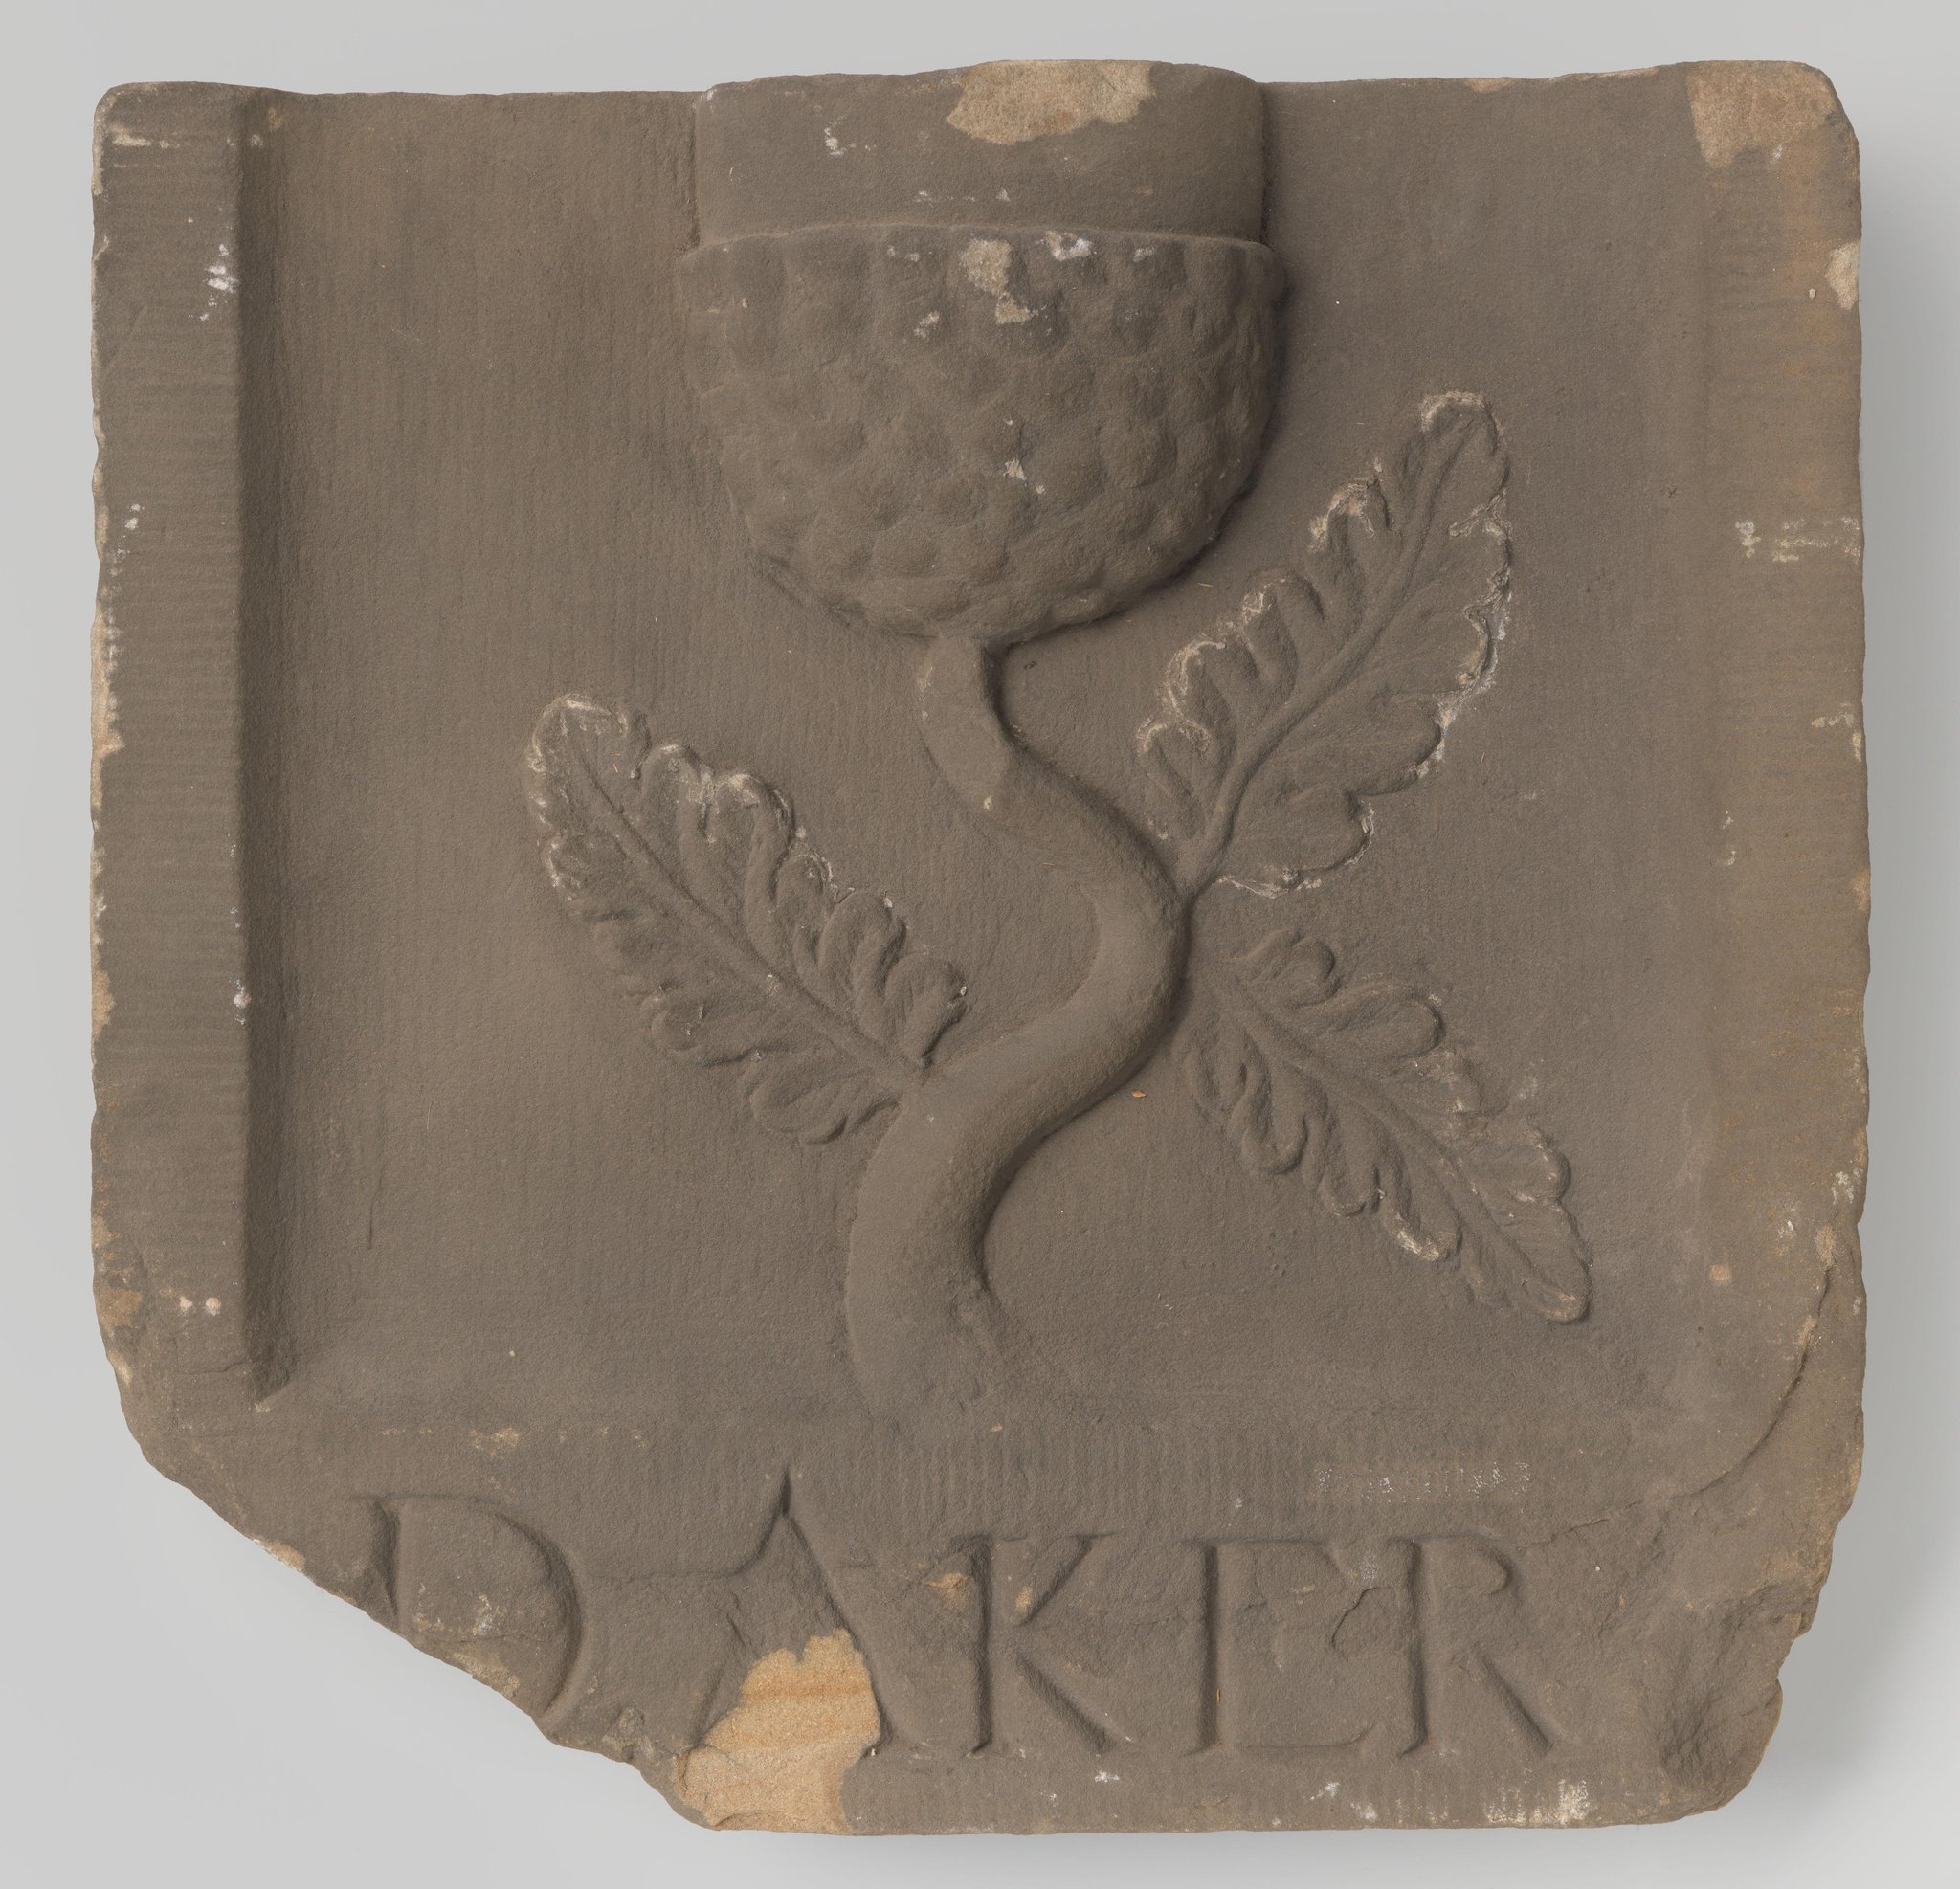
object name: gable stone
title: Gevelsteen met afbeelding van een aker en het opschrift: D AKER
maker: Anonymous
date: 1400-1950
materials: stone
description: Gevelsteen waarop een aker is afgebeeld met onderschrift D AKER. Afkomstig van een huis hoek Damrak en Kapelsteeg.